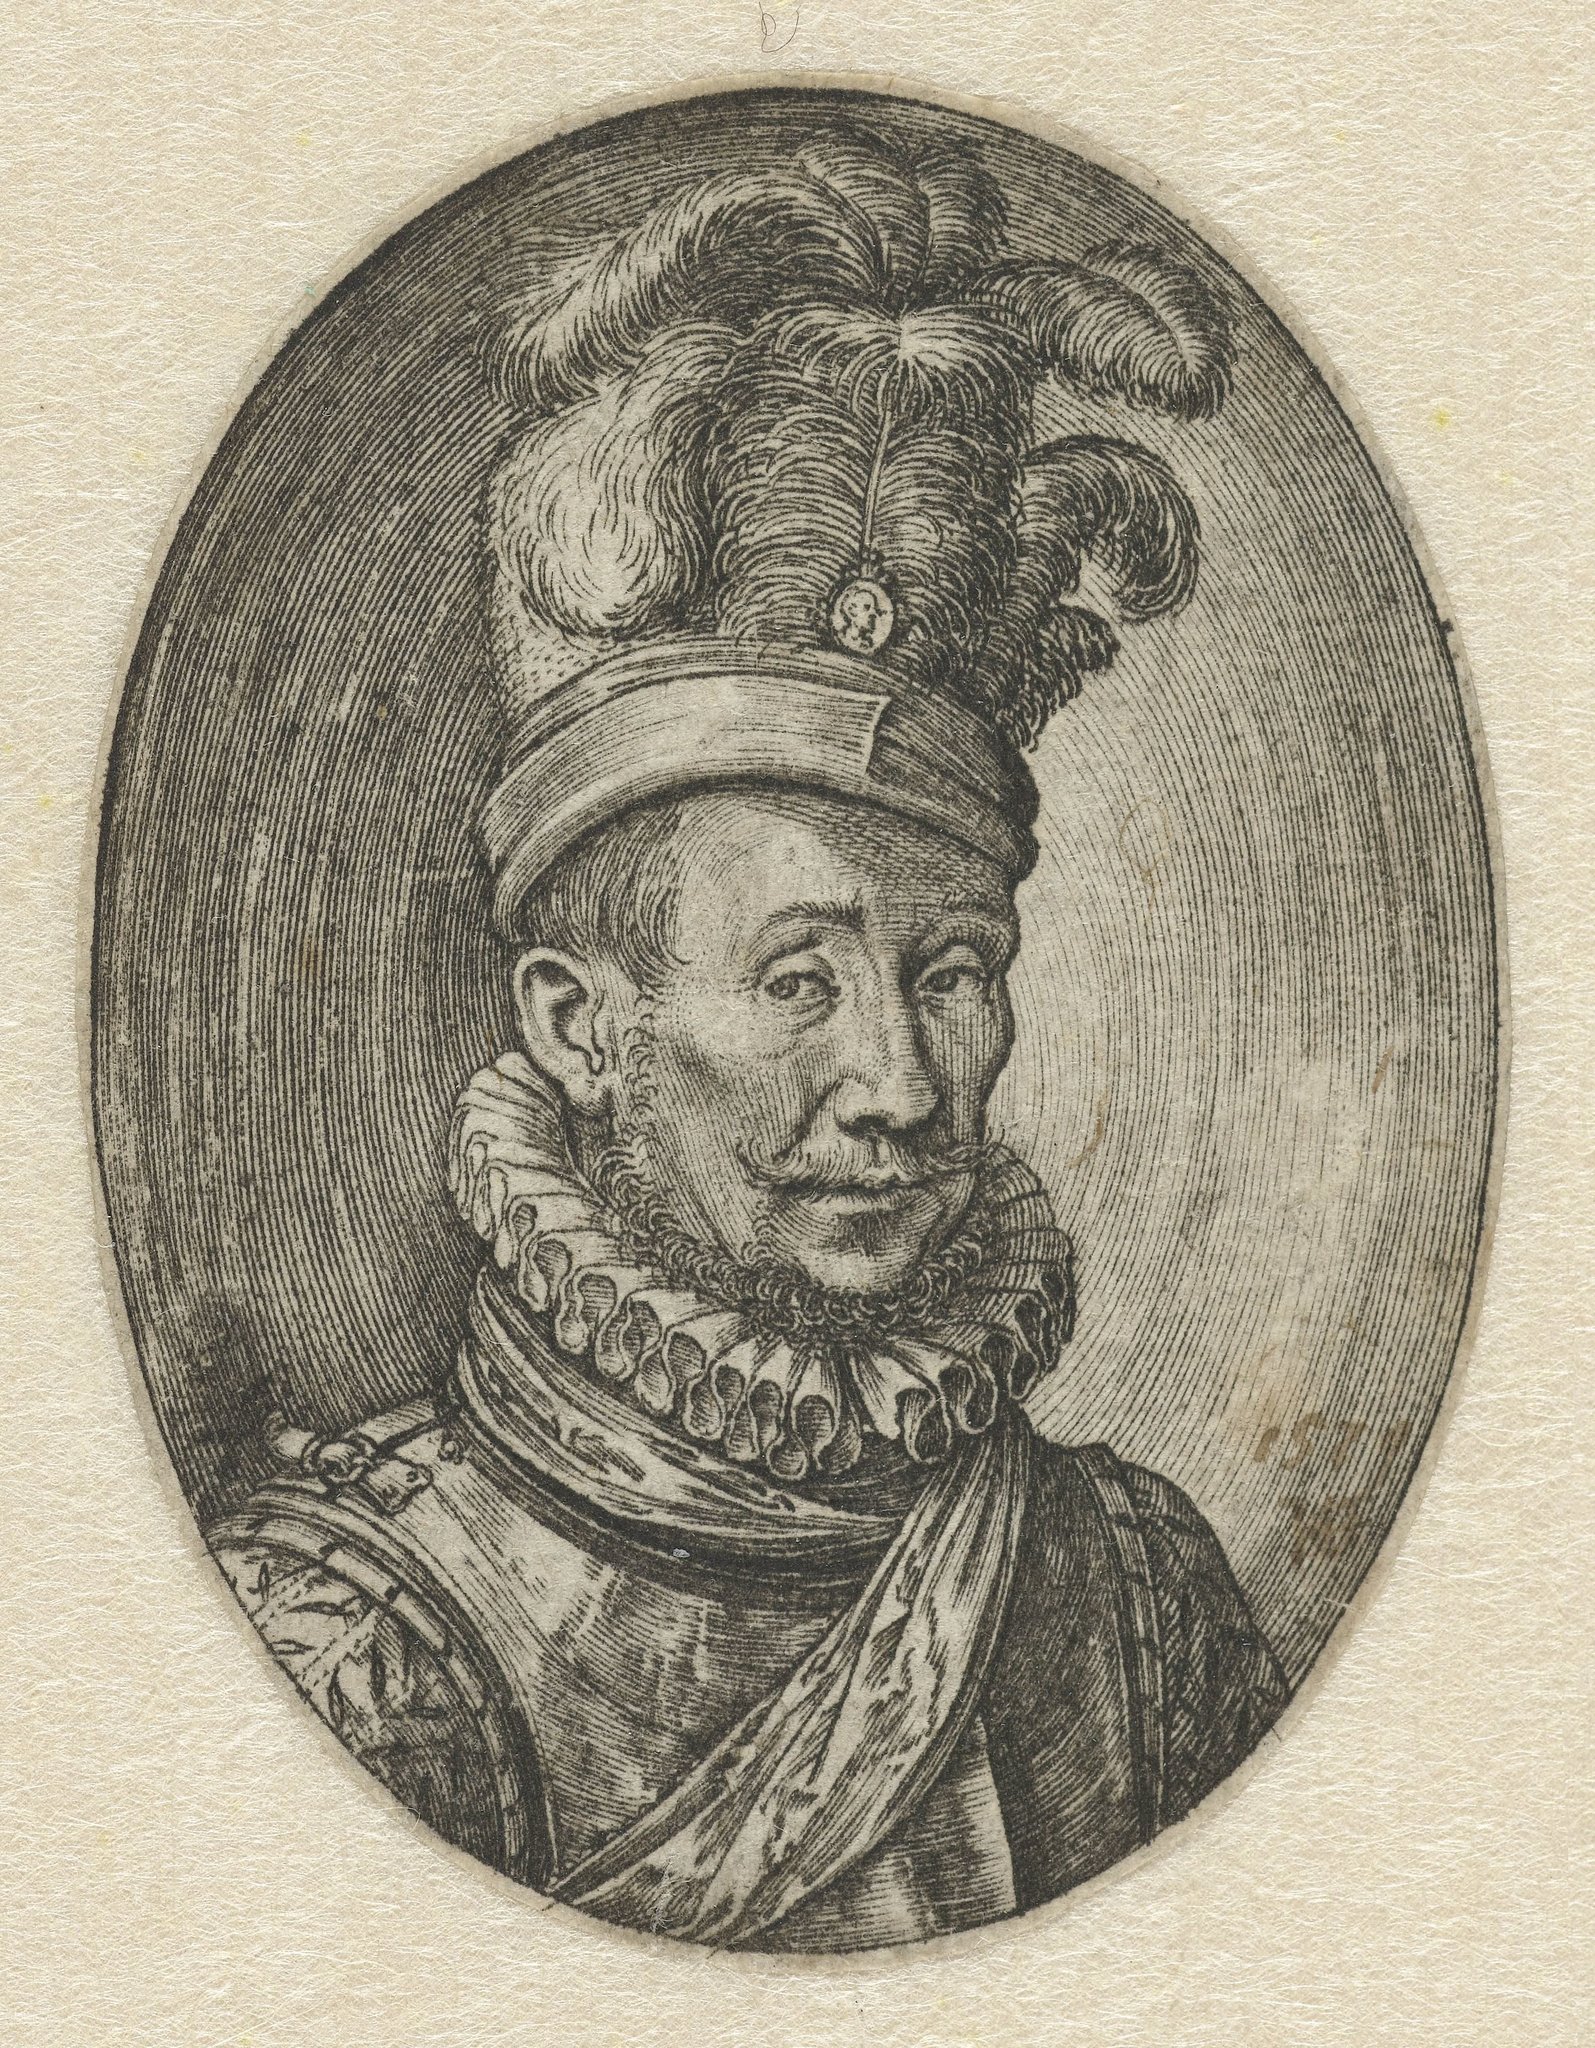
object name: print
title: Portret van een man met een hoge hoed met veren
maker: pieter serwouters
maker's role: draughtsman, print maker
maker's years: 1586-1657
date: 1596-1657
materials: paper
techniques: engraving, pen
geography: amsterdam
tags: neck-gear ~ clothing (with name) (+ men's clothes), anonymous historical person portrayed alone, head-gear: hat (+ men's clothes)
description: Portret ten halven lijve in ovaal van een man met een hoge hoed met veren op het hoofd en een sjerp om het lijf.